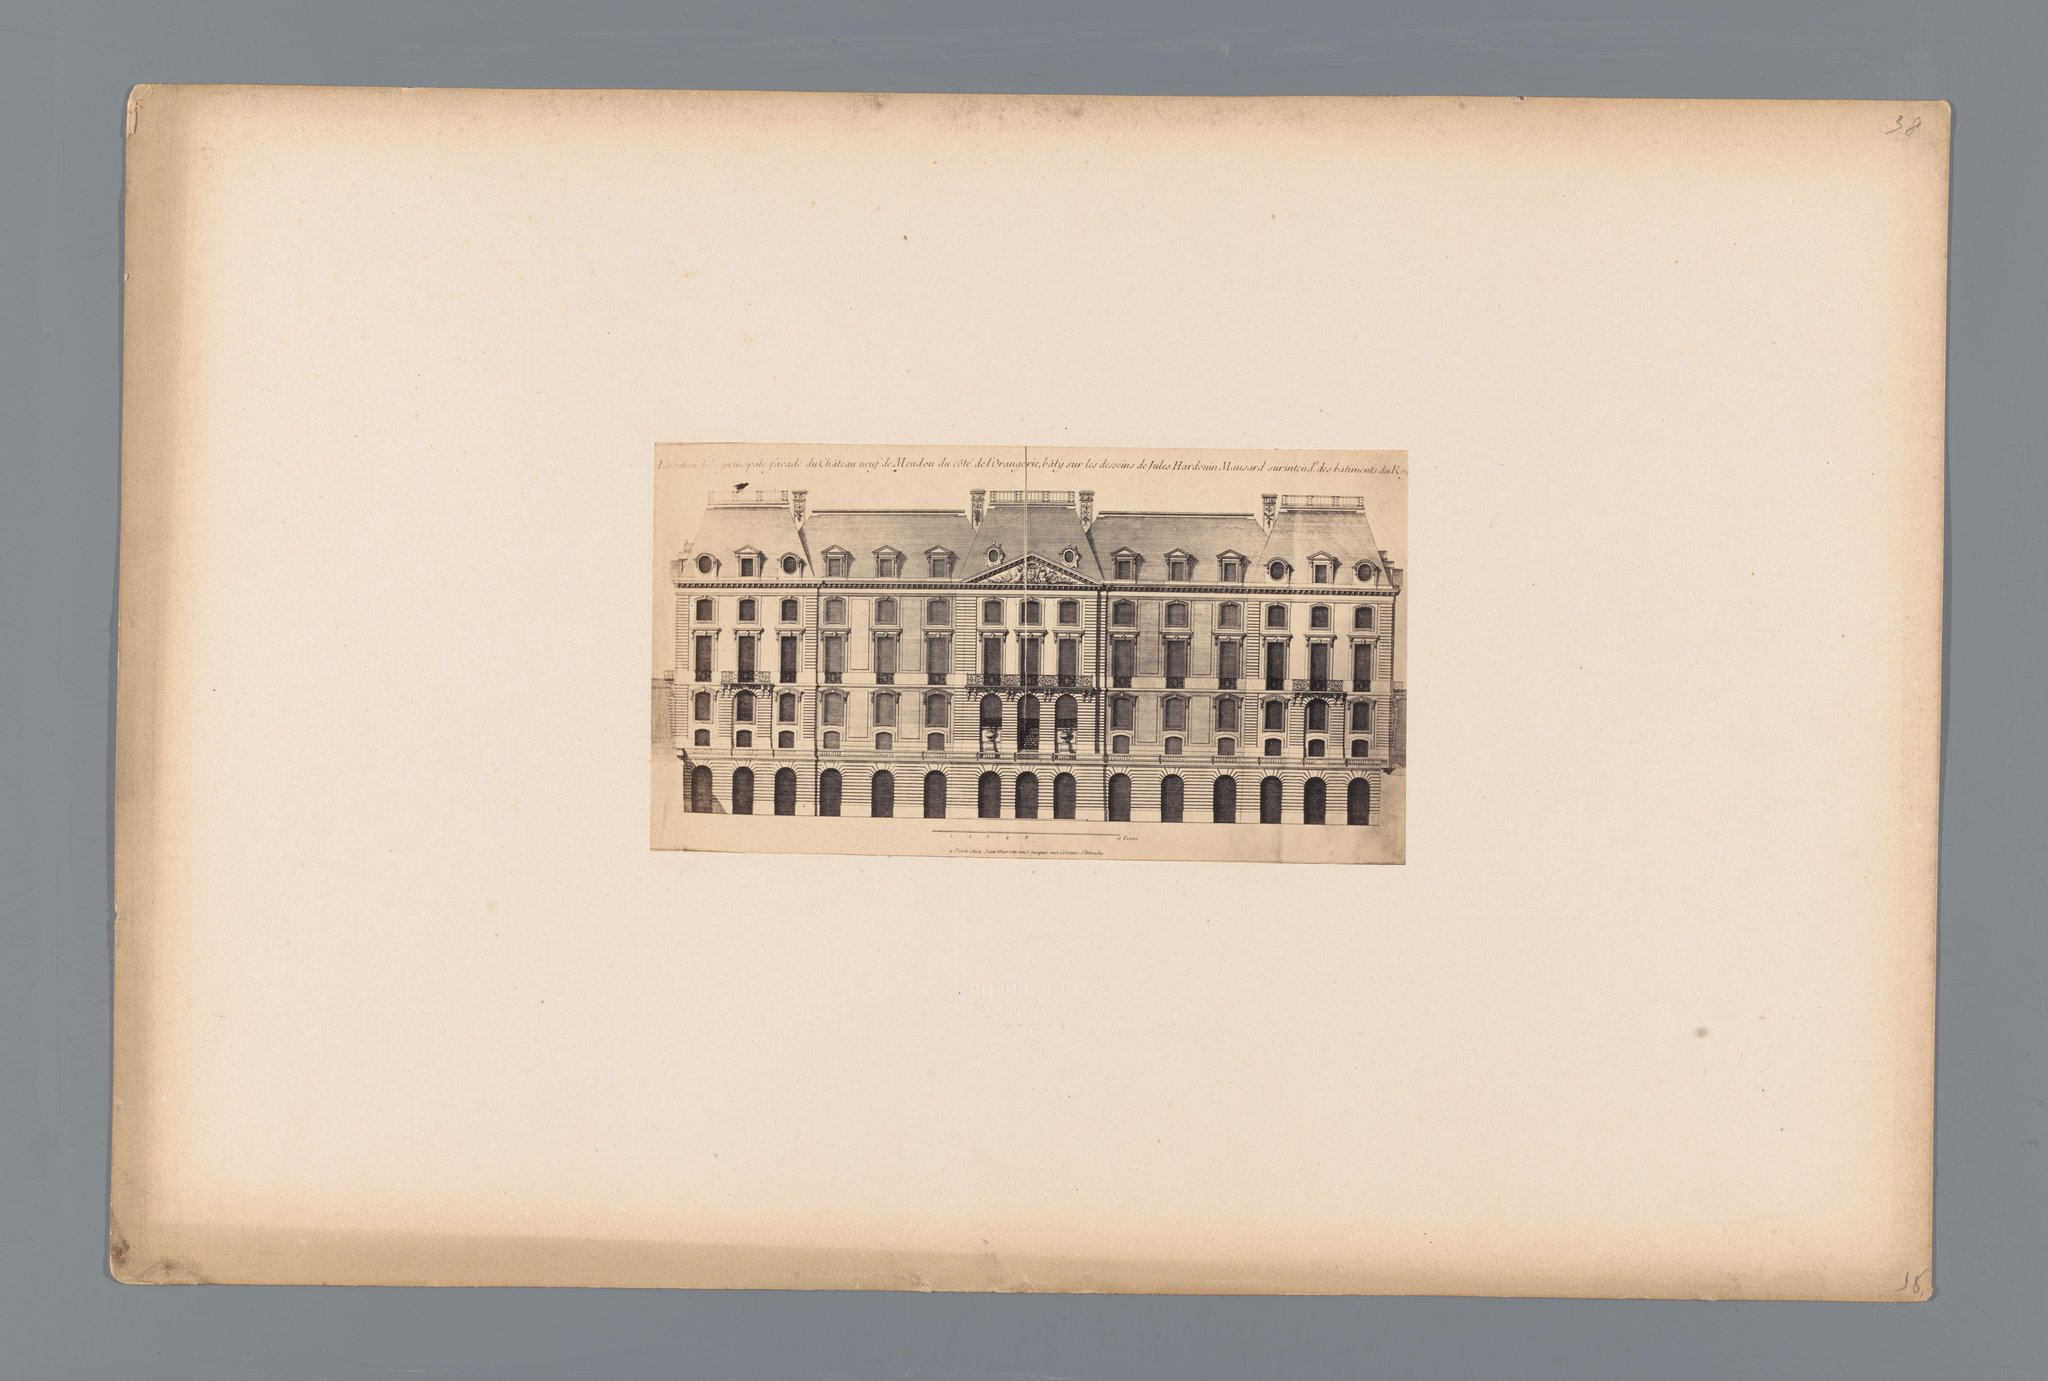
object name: reproduction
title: Fotoreproductie van een ontwerp van het vooraanzicht van het kasteel van Meudon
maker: pierre petit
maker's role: fotograaf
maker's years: 1832-1909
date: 1860-1865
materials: photographic support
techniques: albumen print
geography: paris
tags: castle, front façade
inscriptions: number: ‘38’, check stamp: ‘PHOTOGRAPHIE des DEUX MONDES/ PIERRE PETIT/ 31, Rue Cadet, 31/ PARIS’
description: Deze foto maakt deel uit van een omslag met 38 foto's en 17 tekstbladen.